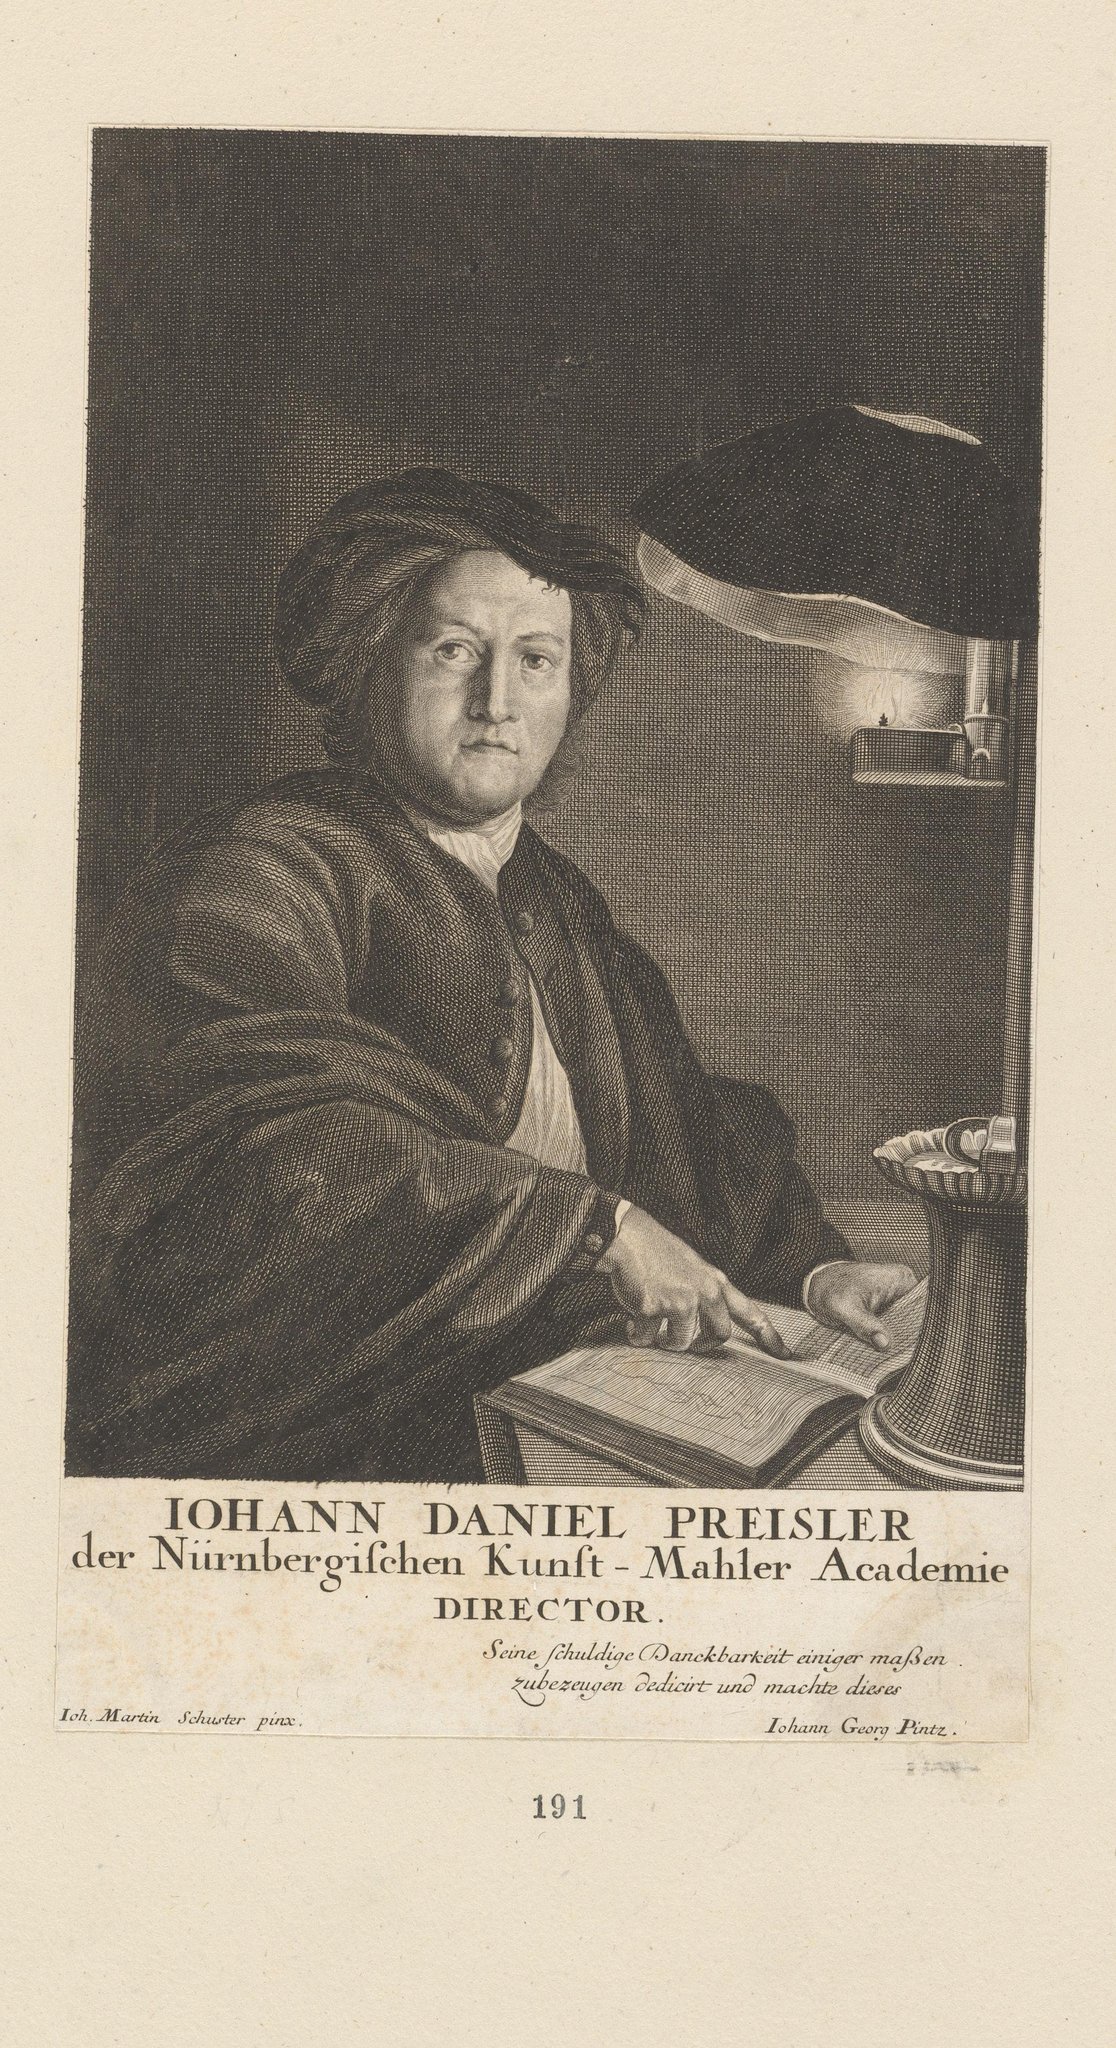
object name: print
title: Portret van de schilder en academie-directeur Johann Daniel Preissler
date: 1730-1750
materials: paper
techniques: engraving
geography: nuremberg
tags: print maker, draughtsman, johann daniel preissler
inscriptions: collector's mark